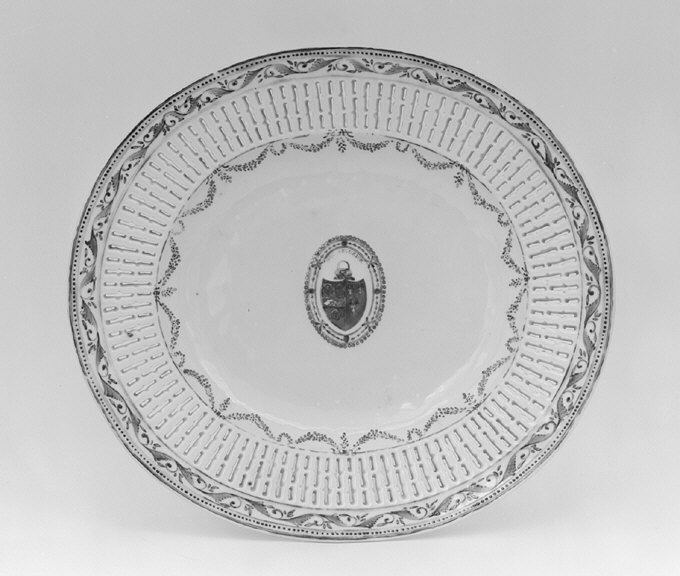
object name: tray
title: Tray (part of a service)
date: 1770-1785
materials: hard paste porcelain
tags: coat of arms